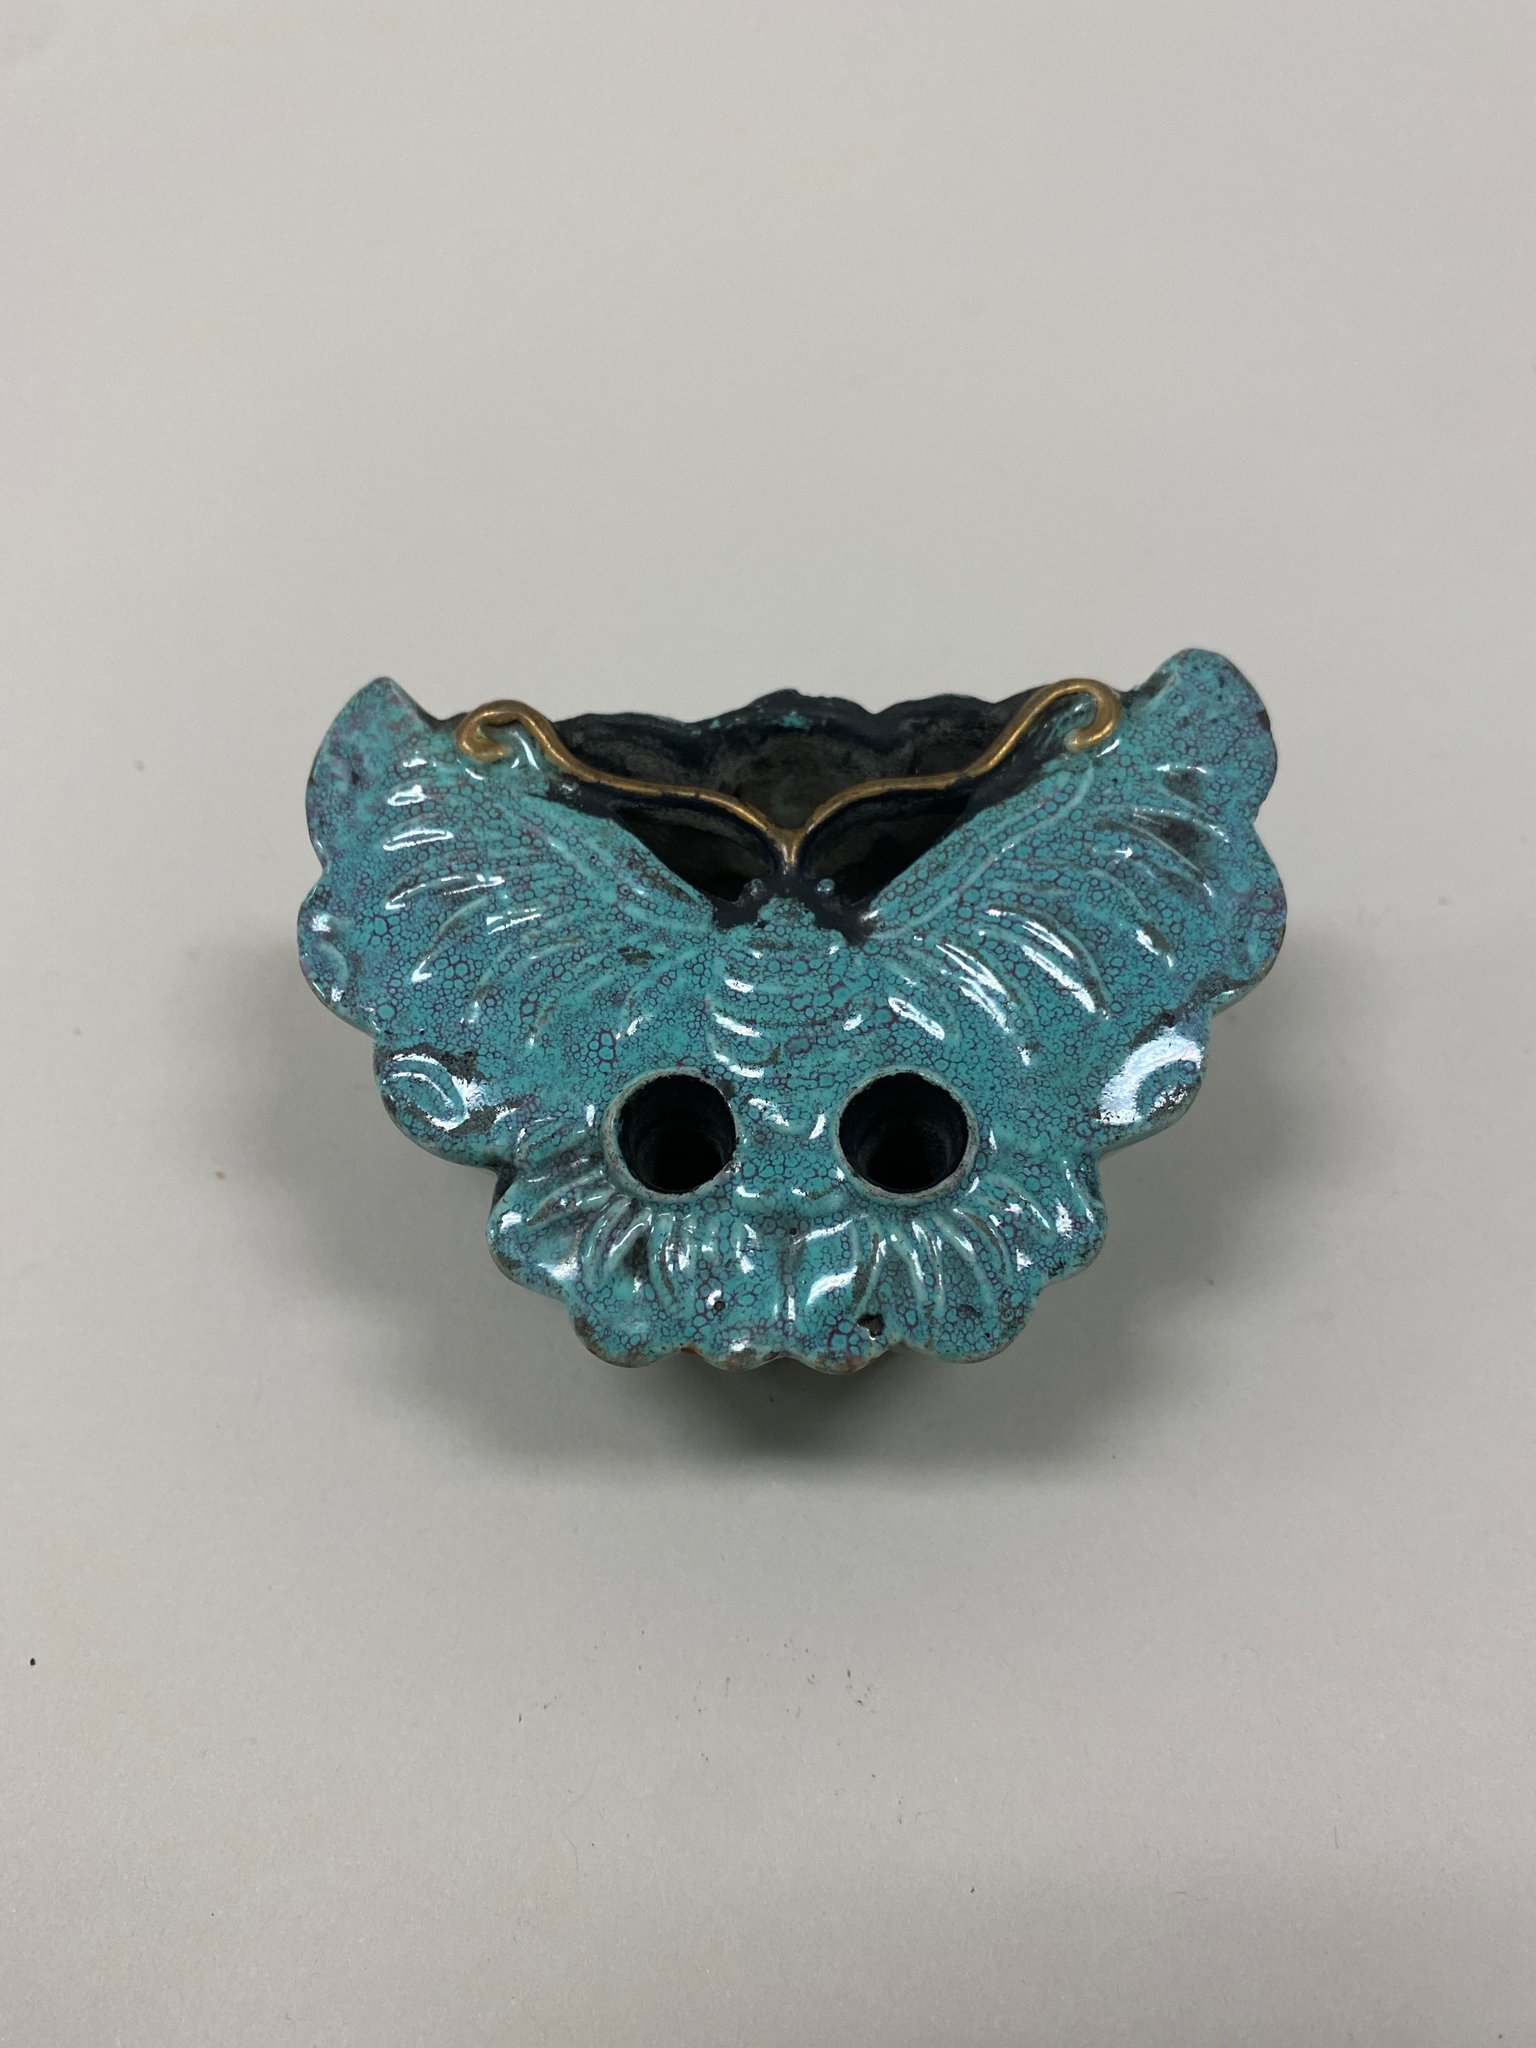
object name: water pot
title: Washer in the shape of a butterfly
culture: chinese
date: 1801-1900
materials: glaze, porcelain